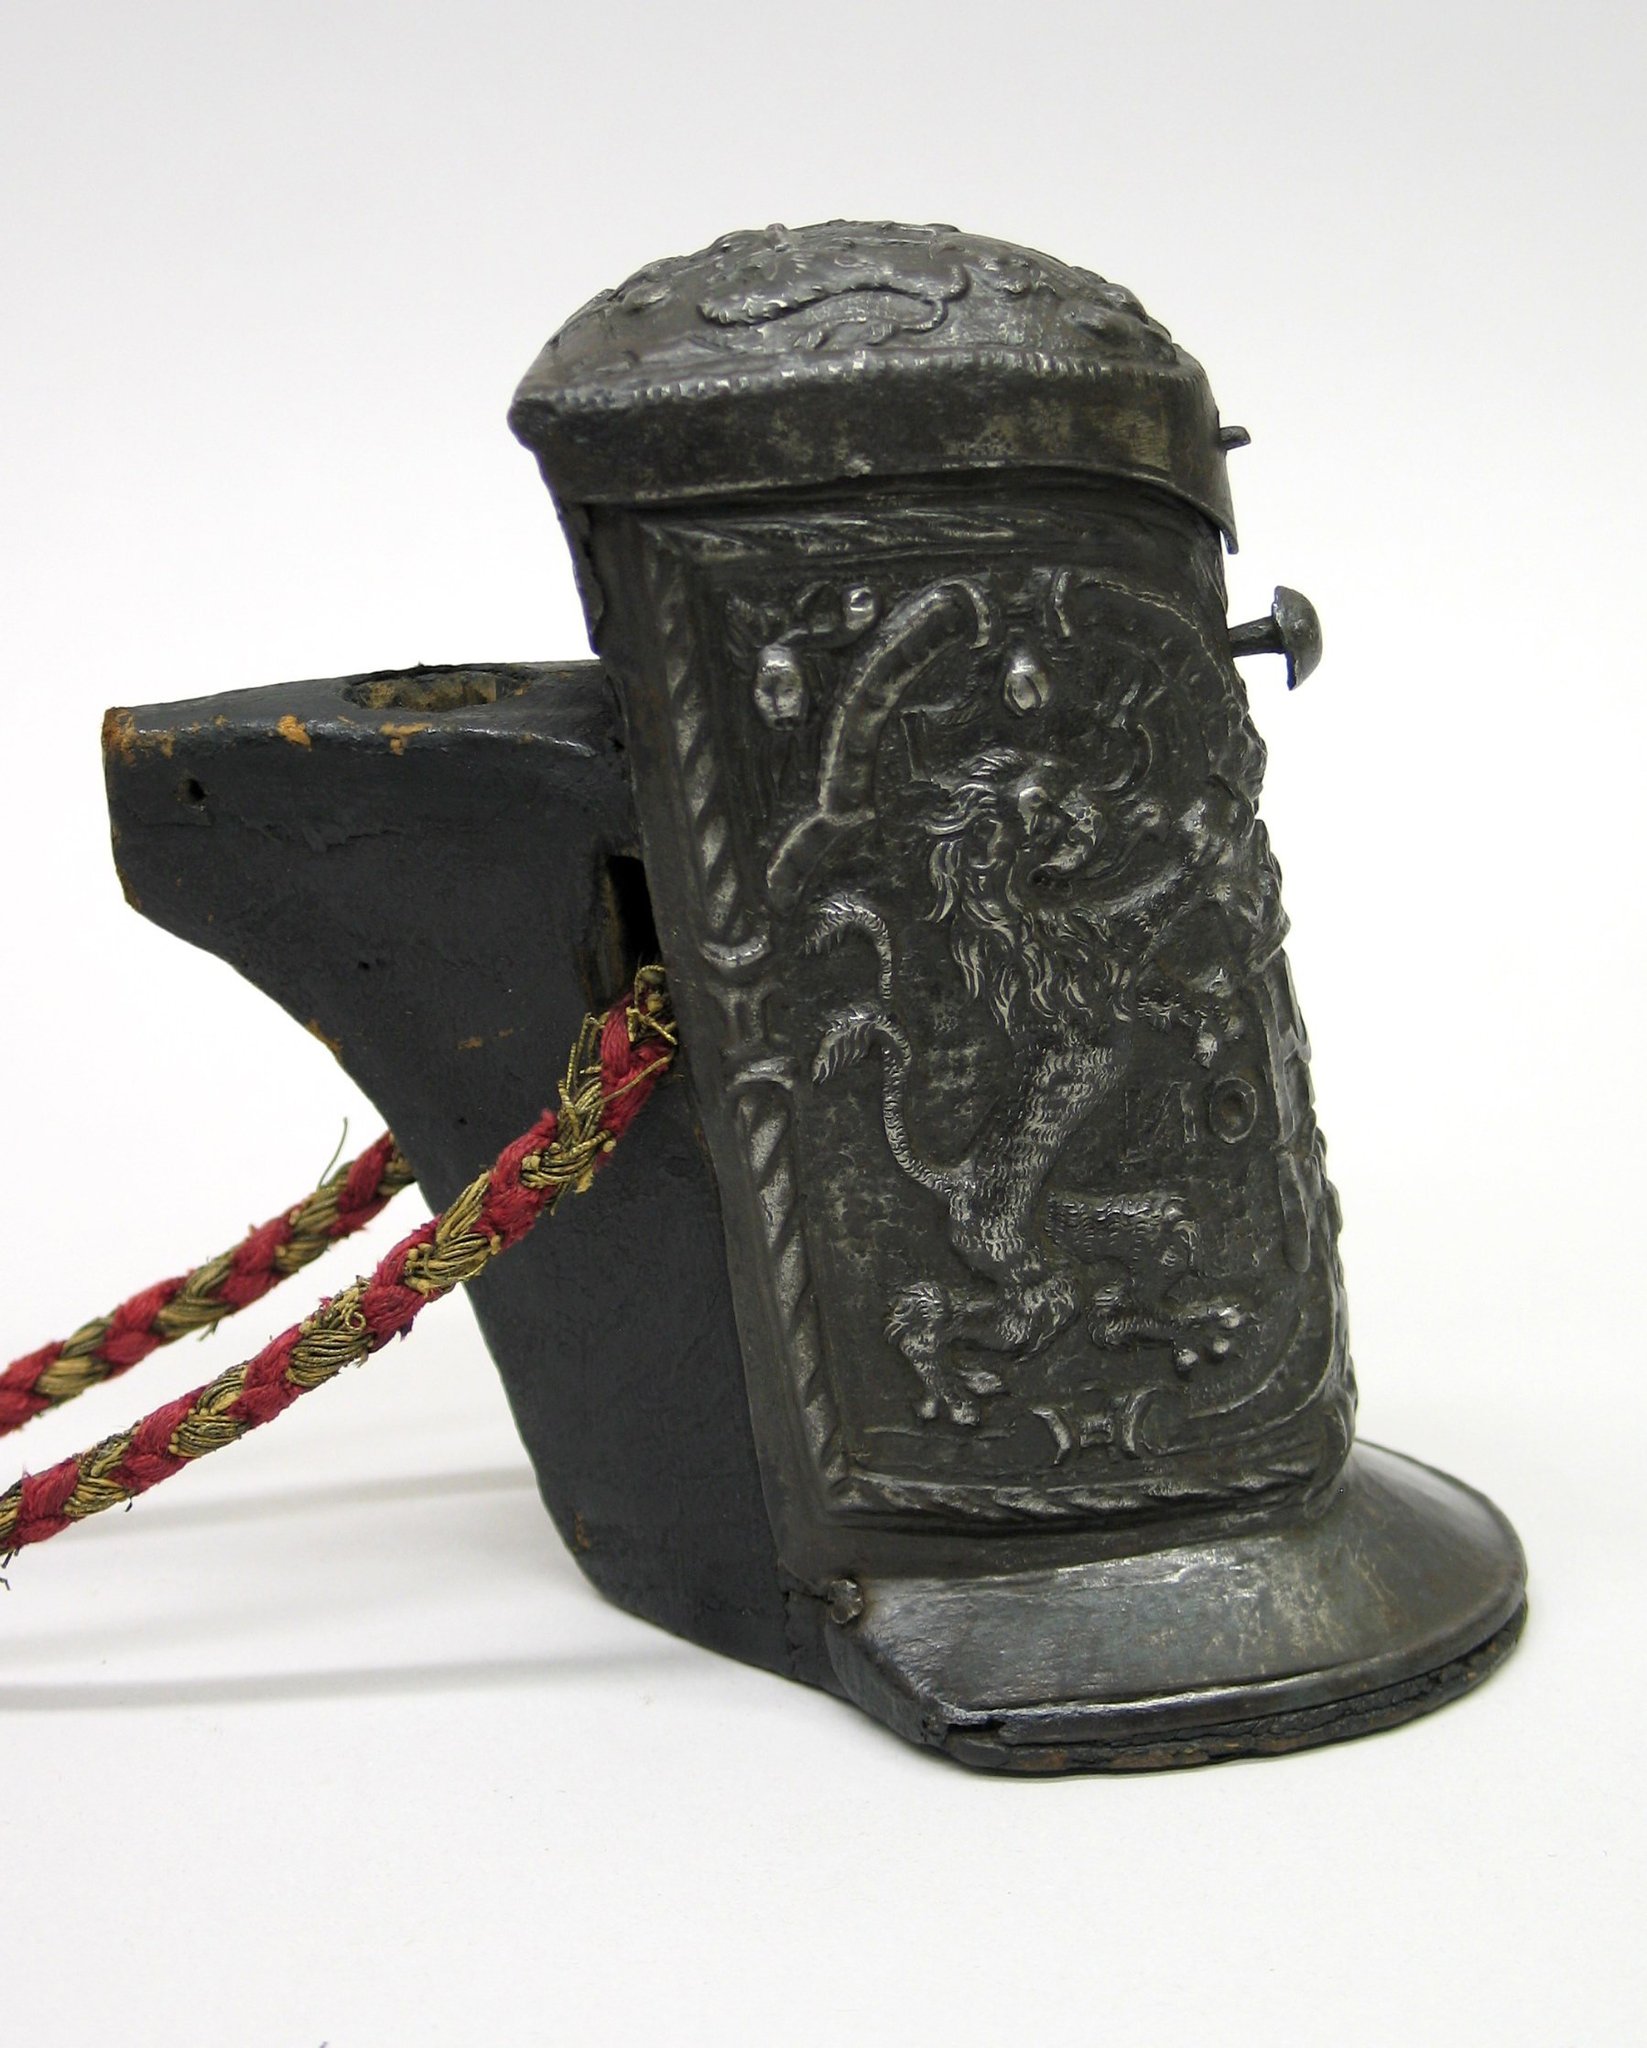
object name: cartridge box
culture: german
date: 1571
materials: iron, leather, metal thread, textile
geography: germany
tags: lions